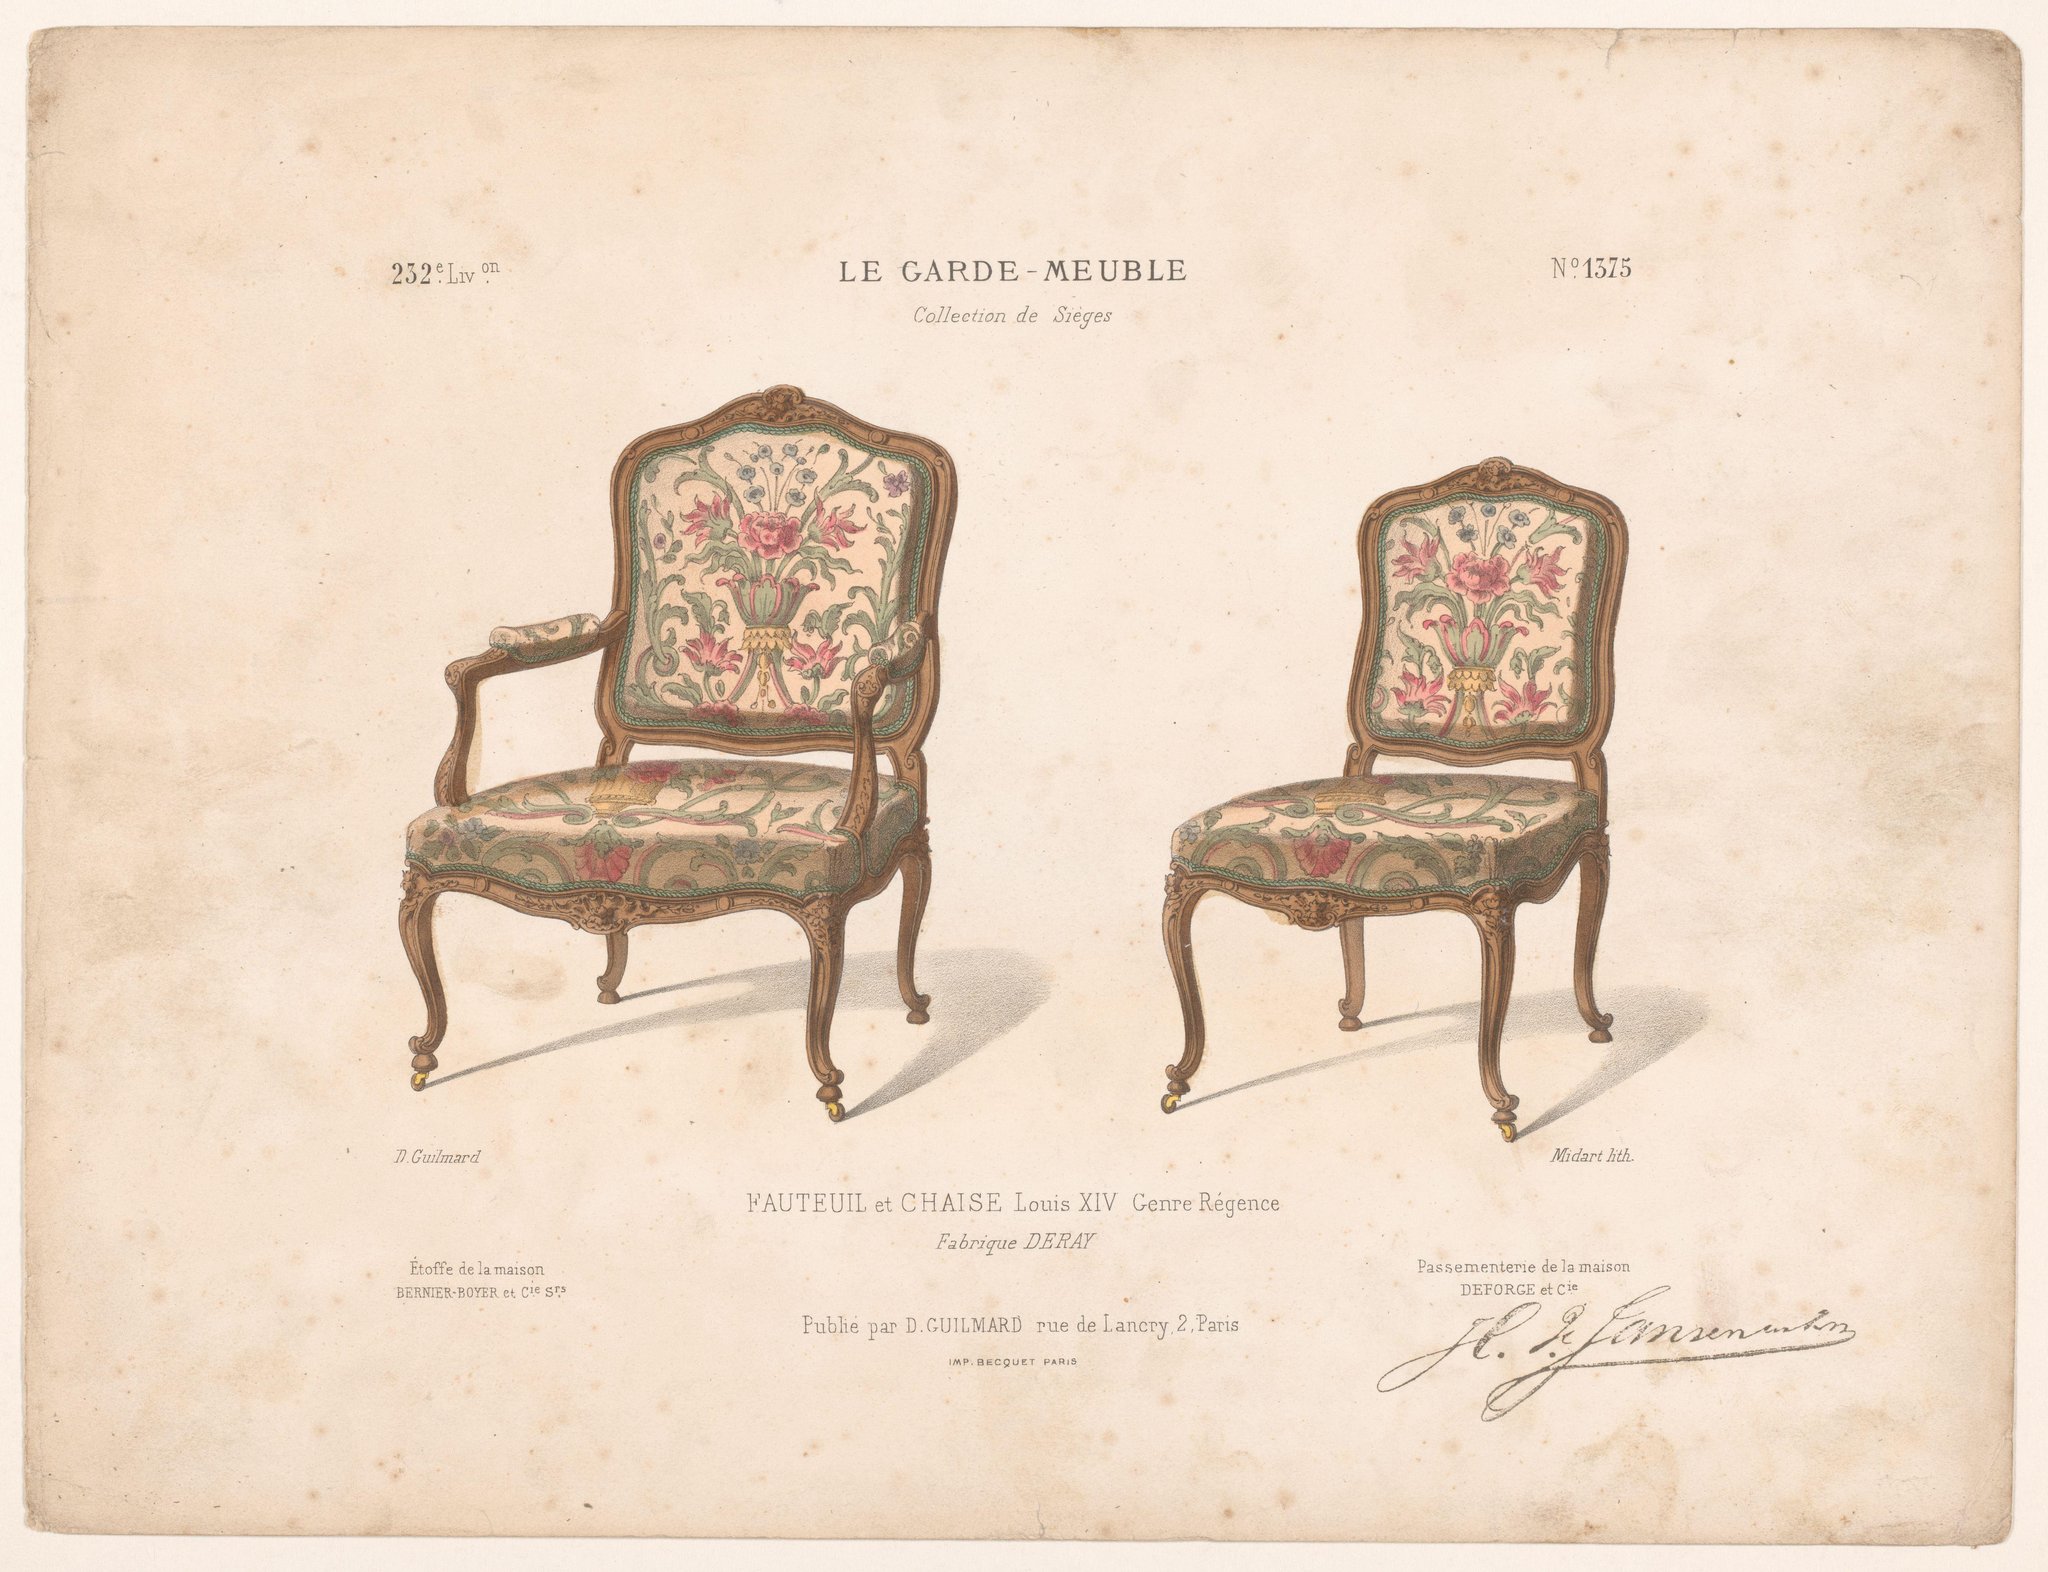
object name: print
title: Fauteuil en stoel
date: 1839-1885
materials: paper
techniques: hand coloring, lithograph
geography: paris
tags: seating furniture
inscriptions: stamp: ‘H.F. Jansen en Zn’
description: Ieder Livraison in de serie Le Garde-Meuble bevat negen platen: drie 'sièges' (zitmeubels), drie 'meubles' (diverse meubels zoals tafels en kasten) en drie 'tentures' (gordijnen en draperieën).